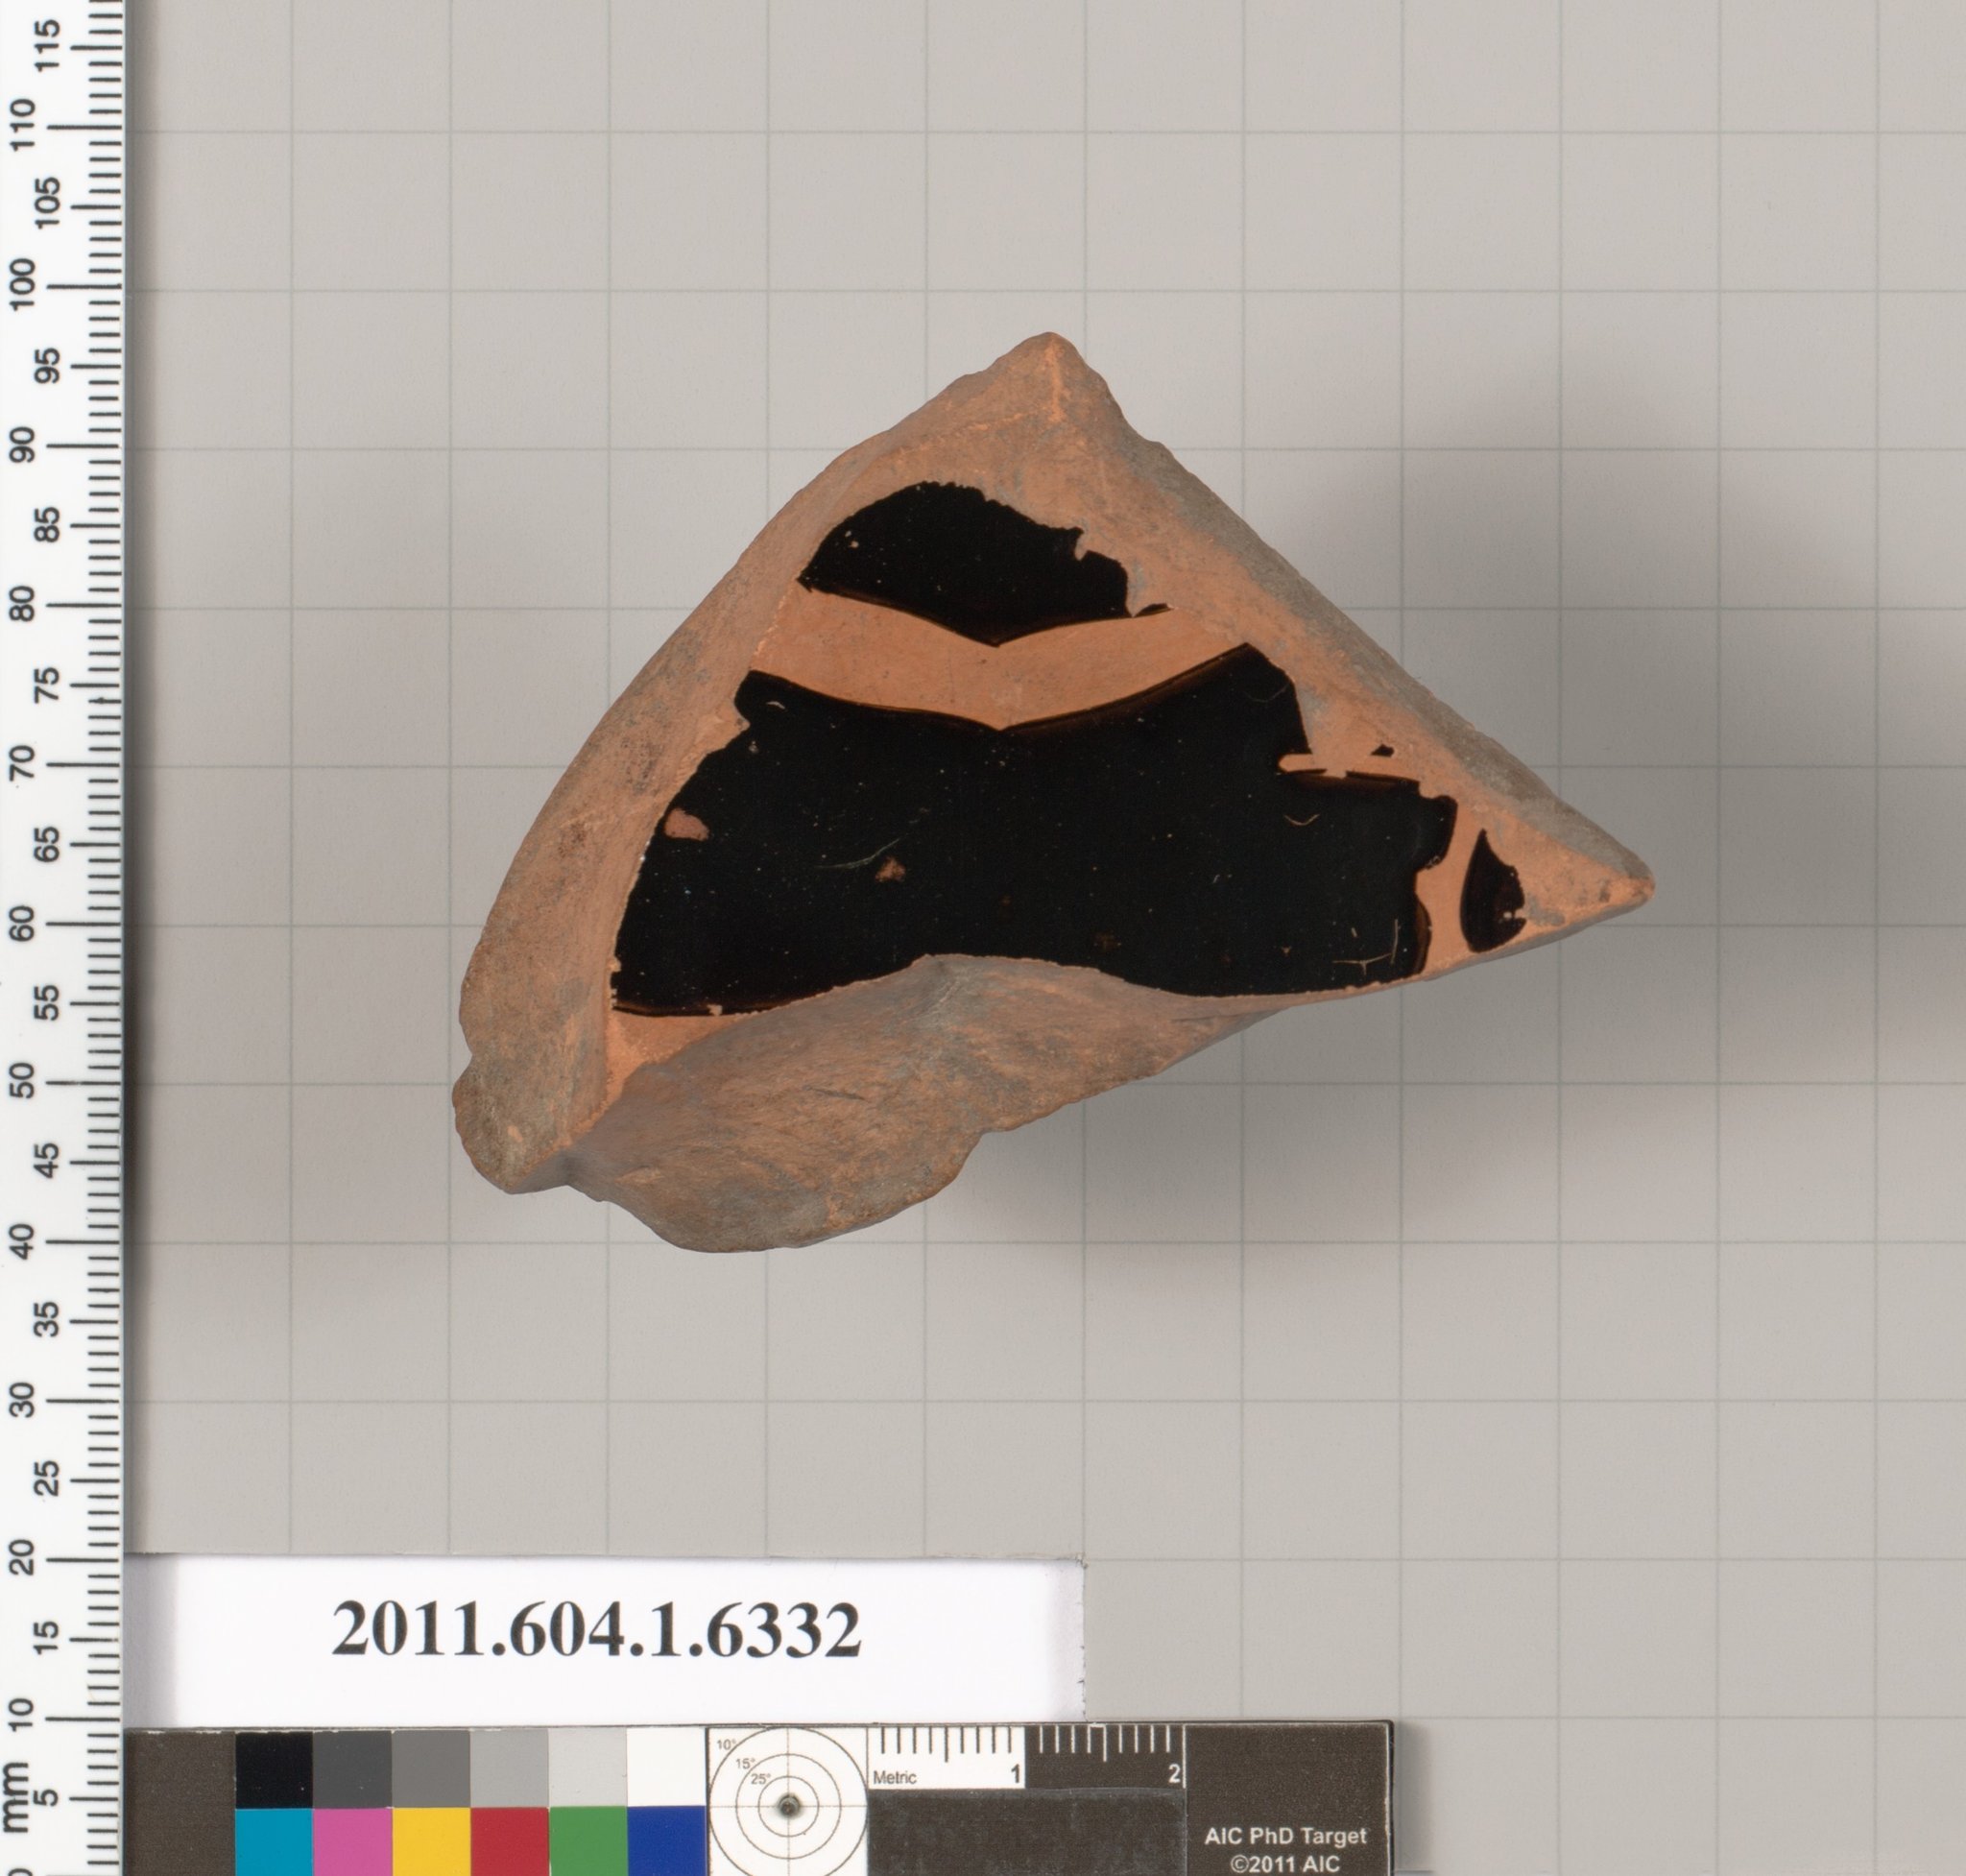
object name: kylix fragment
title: Terracotta fragment of a kylix (drinking cup)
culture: greek, attic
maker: onesimos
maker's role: artist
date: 500-480 BCE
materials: terracotta